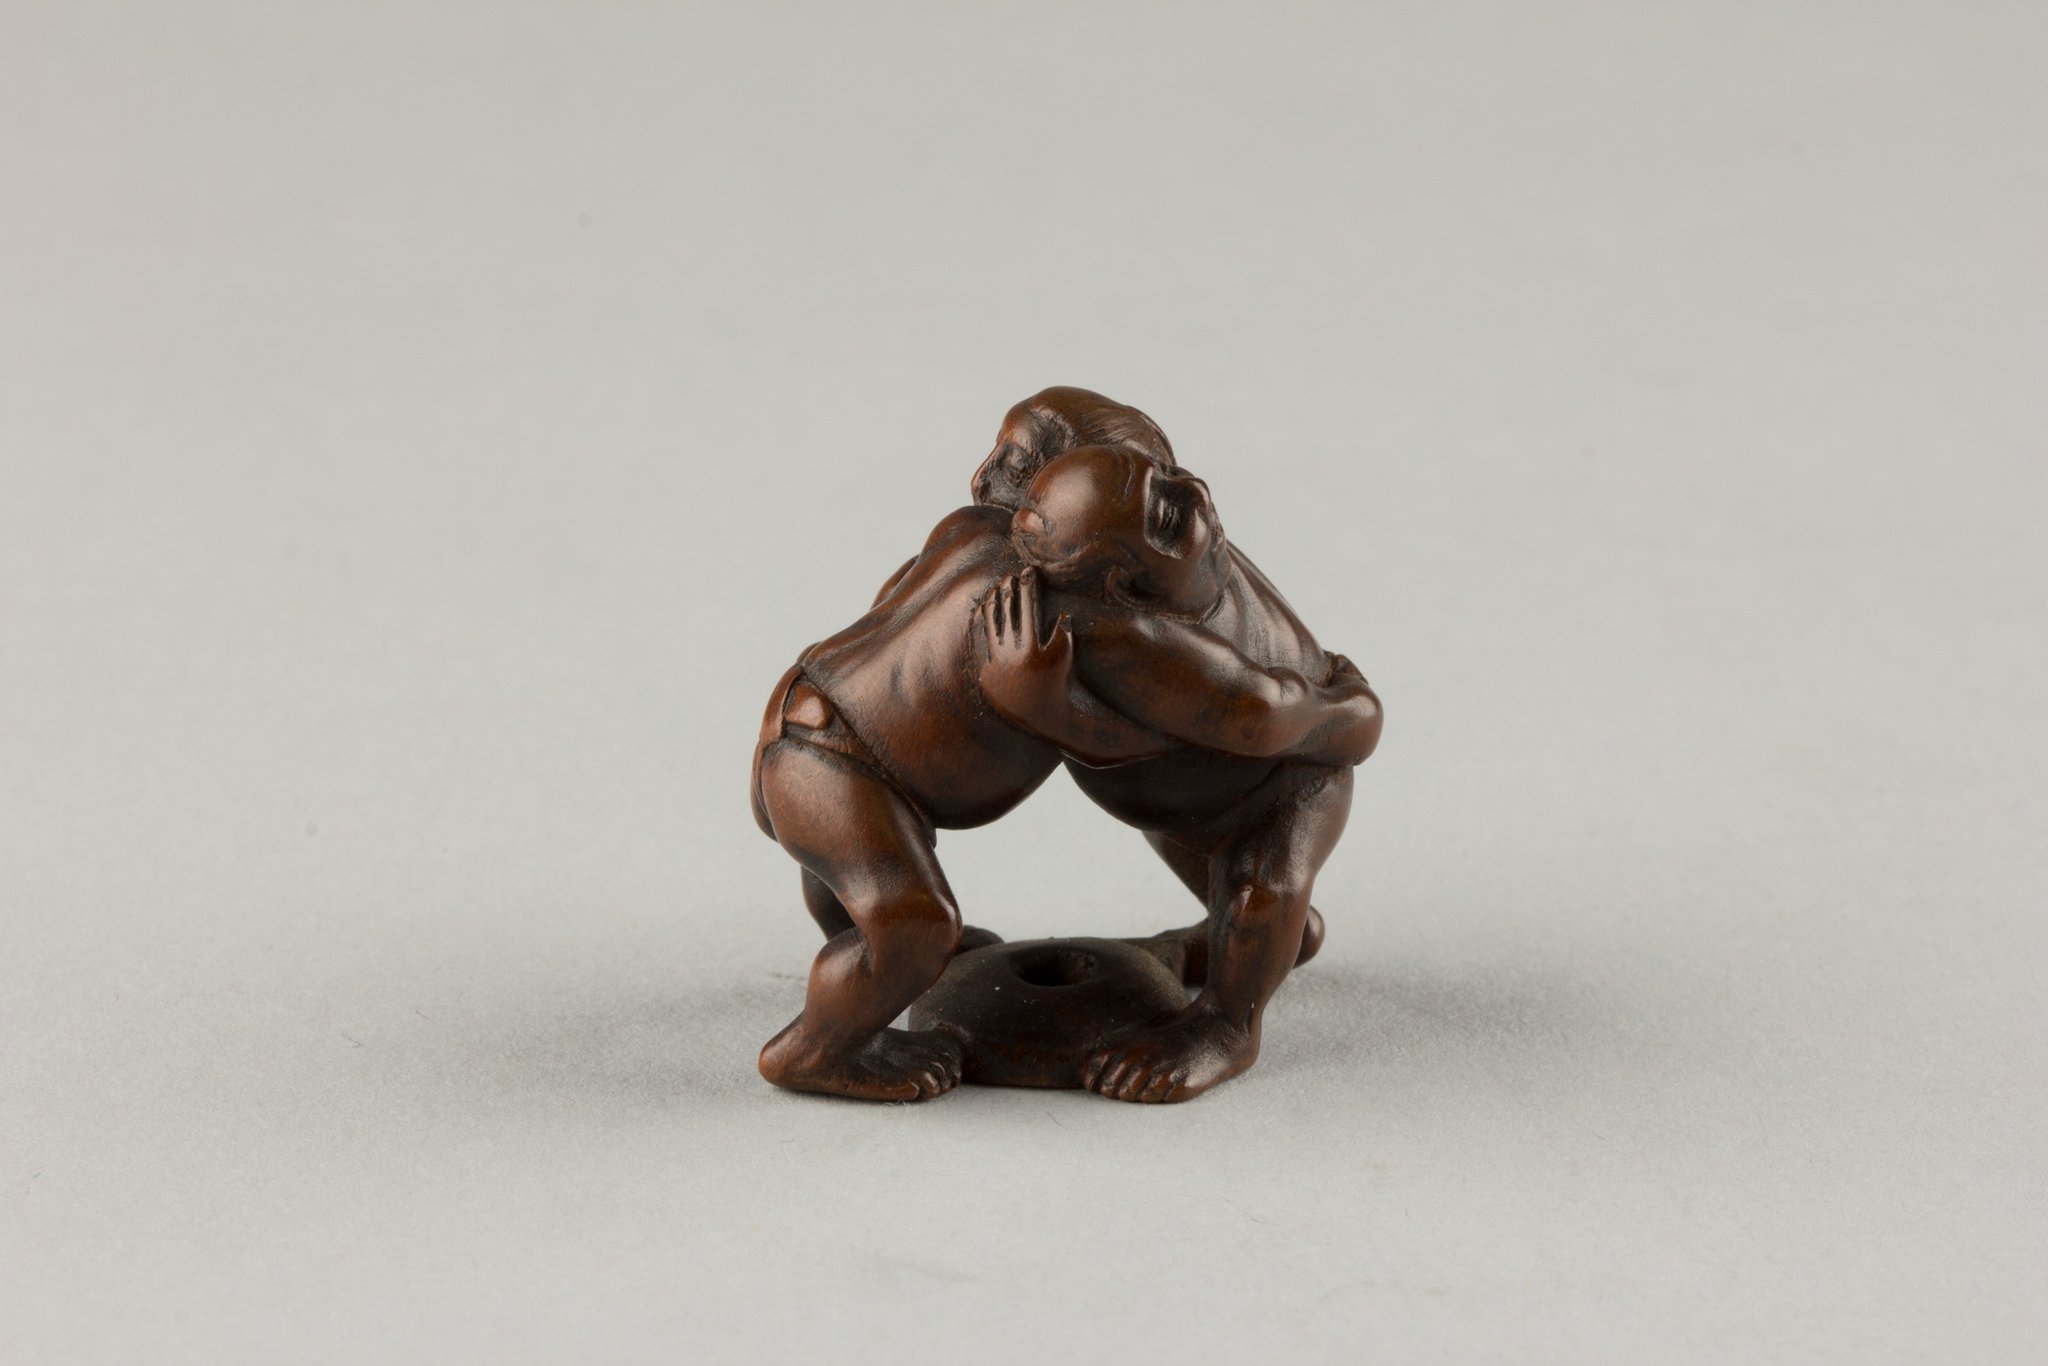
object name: netsuke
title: Netsuke of Two Men Wrestling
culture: japanese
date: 1801-1900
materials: wood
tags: men